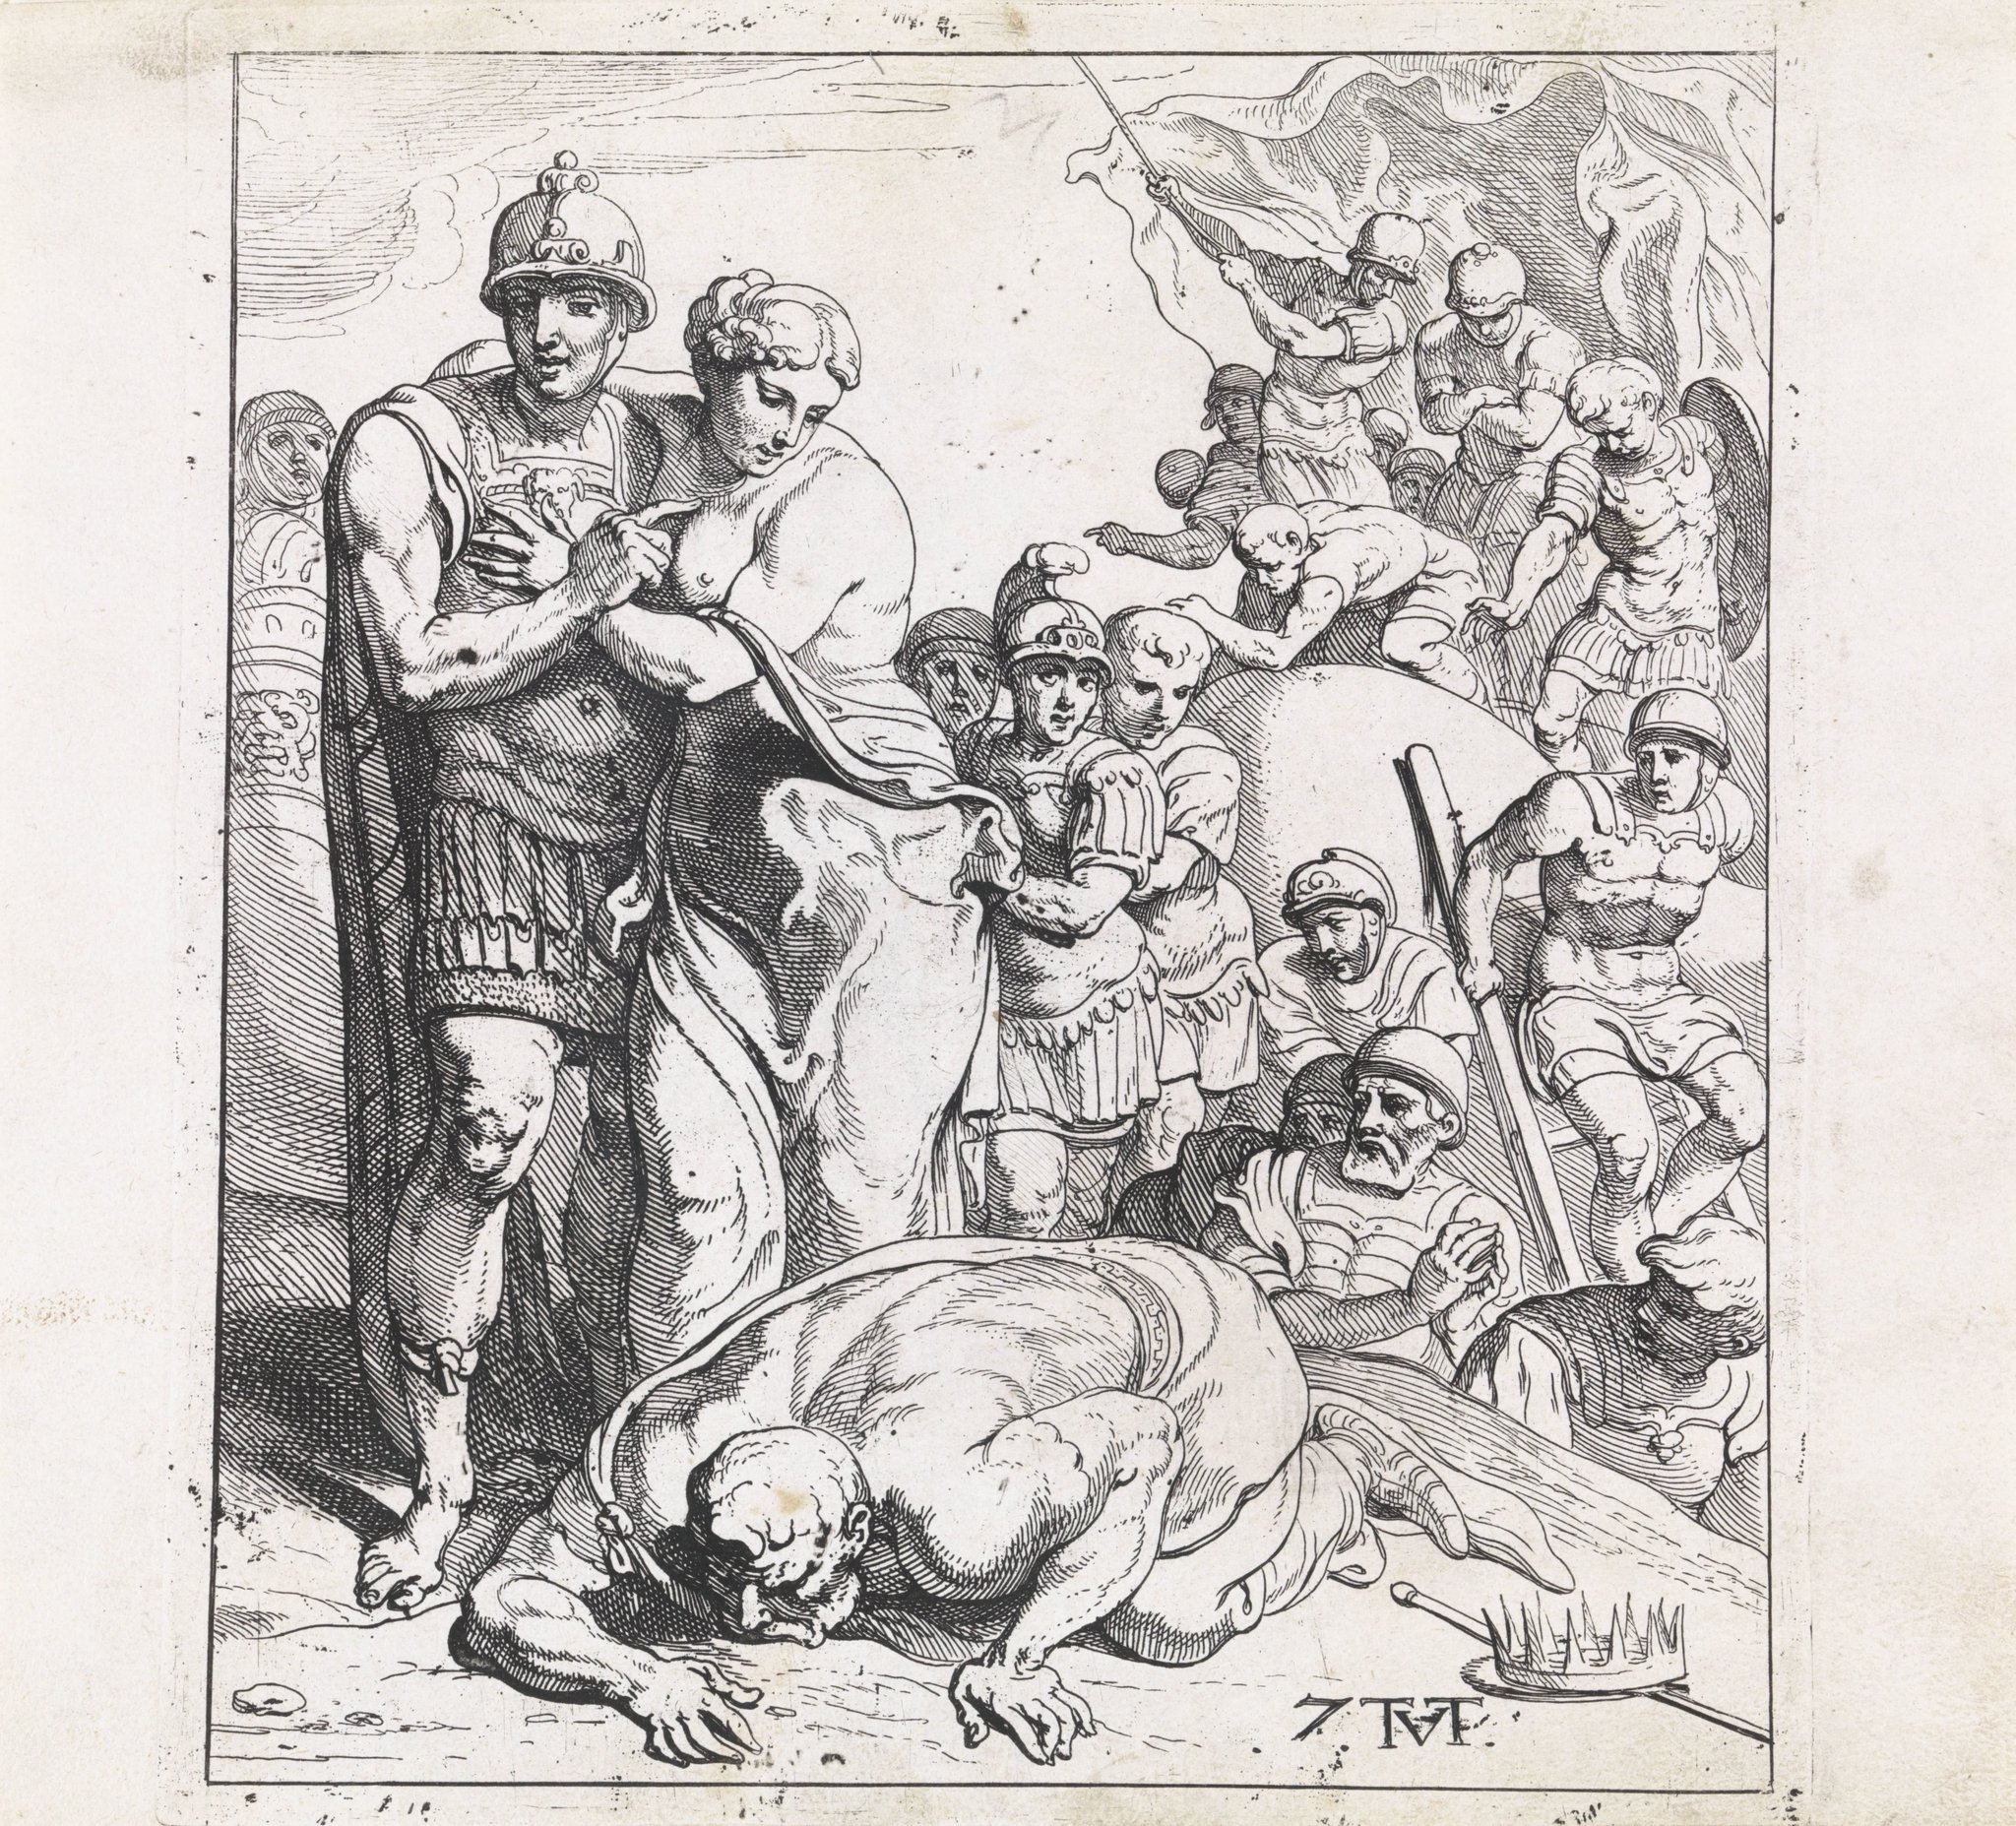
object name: print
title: De werken van Odysseus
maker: theodoor van thulden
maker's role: draughtsman, painter, print maker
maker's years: 1606-1669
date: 1632-1633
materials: paper, pencil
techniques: engraving, etching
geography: paris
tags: arrival of agamemnon and cassandra in mycenae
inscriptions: collector's mark: Lugt 2228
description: Agamemnon keert met Cassandra als oorlogsbuit terug in Mycene. Agamemnon kust de grond van zijn vaderland. Een van zijn mannen staat naast Cassandra, terwijl de andere mannen van boord gaan.